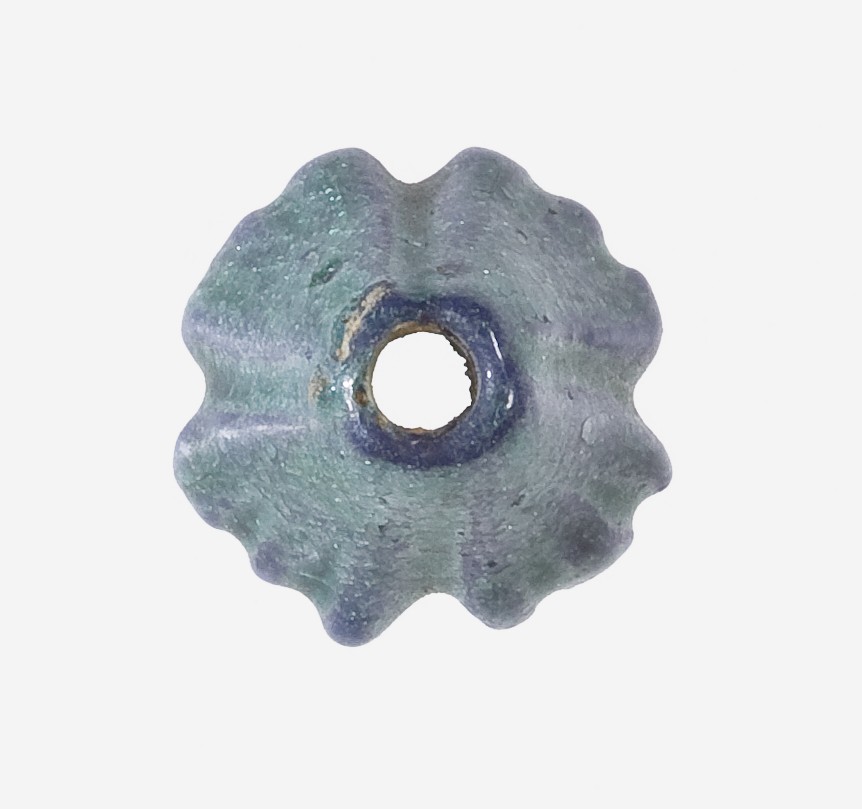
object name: pendant, cornflower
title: Pendant: Petals of Cornflower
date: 1390-1352 BCE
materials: faience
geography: egypt